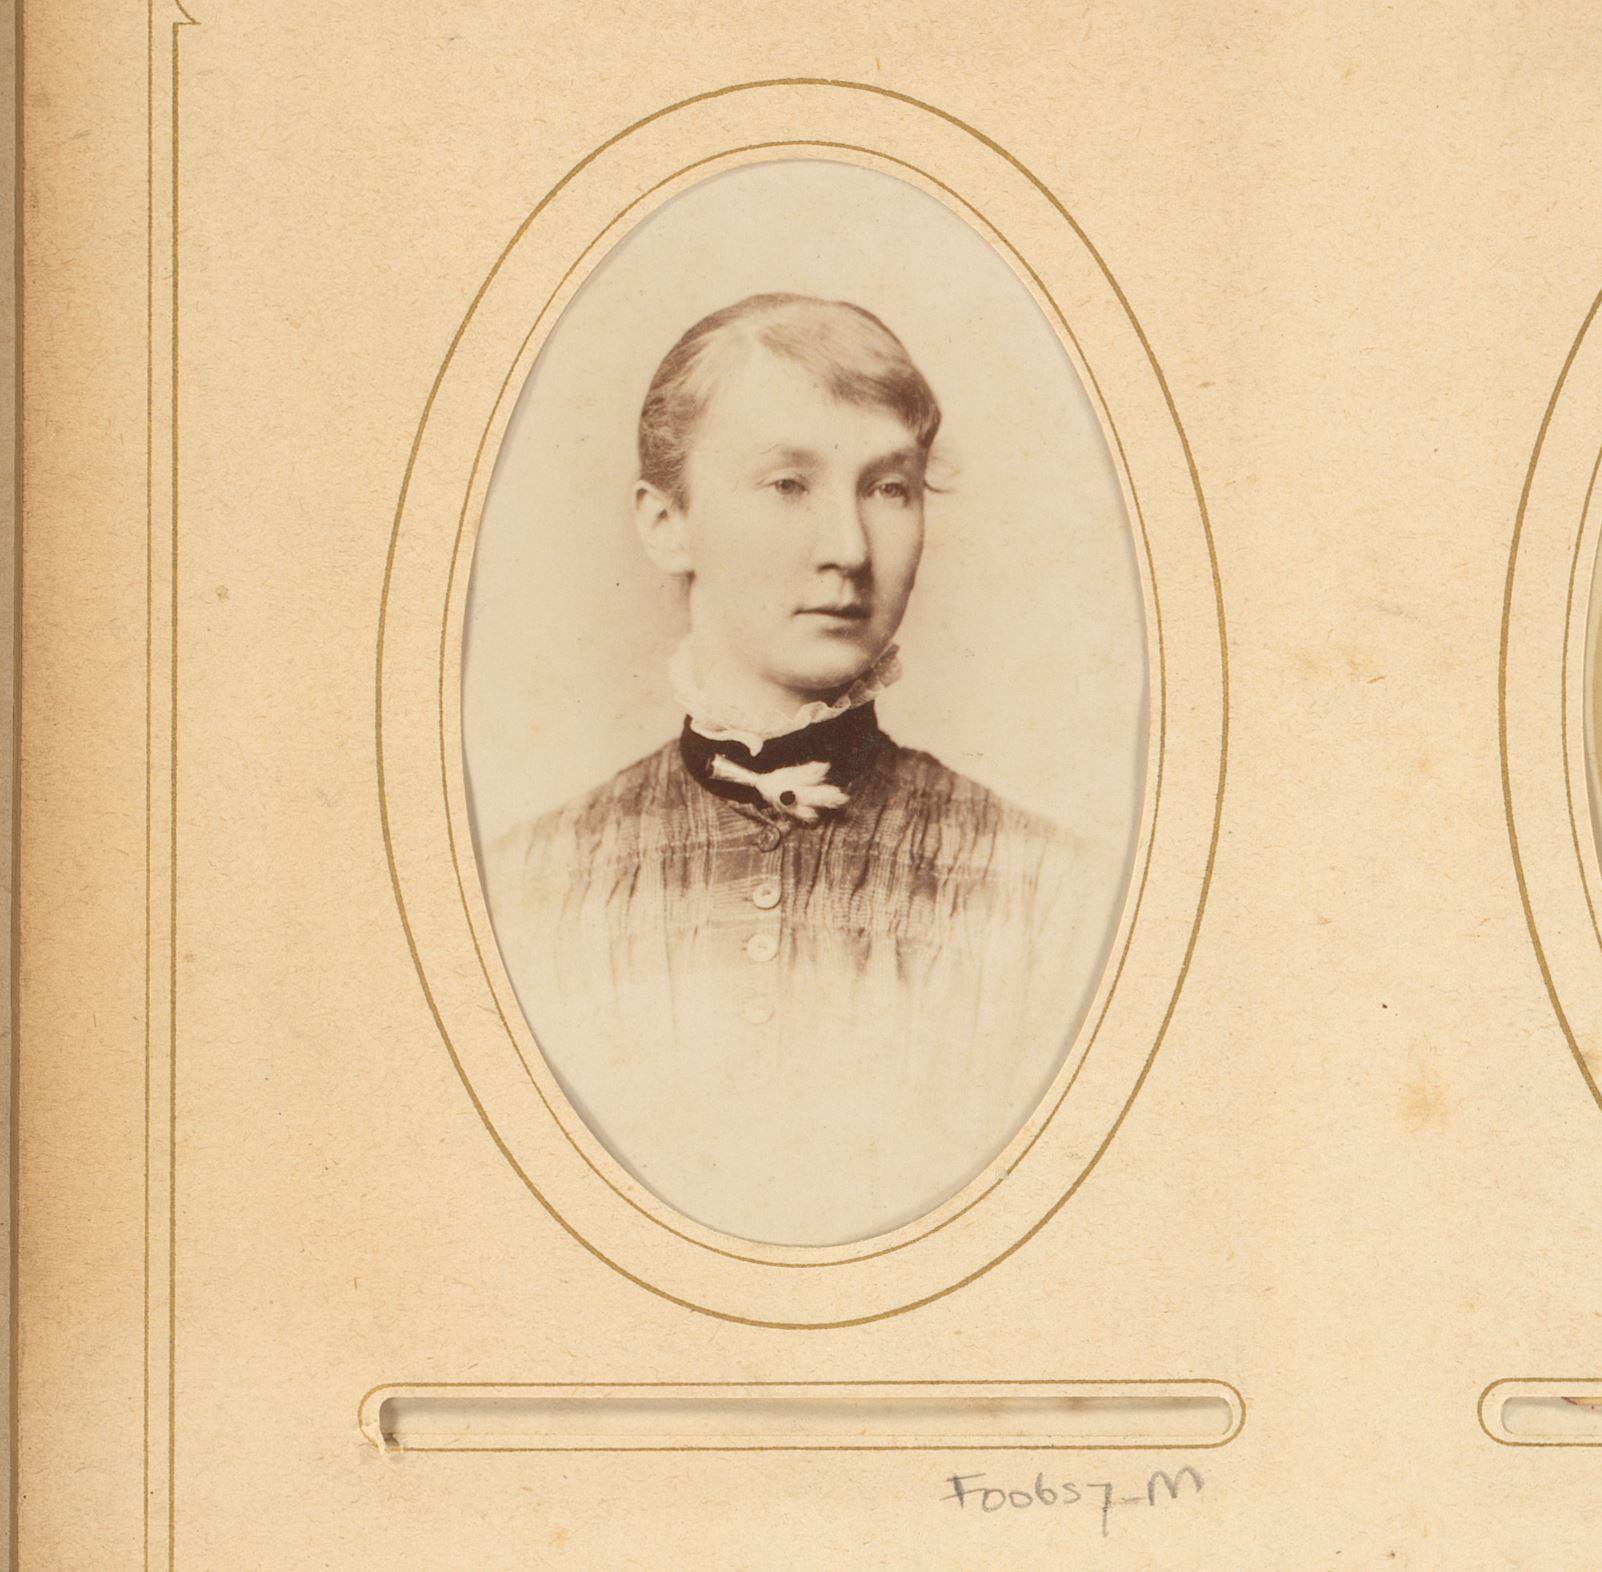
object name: carte de visite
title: Portret van een vrouw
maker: valentine blanchard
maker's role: fotograaf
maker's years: 1831-1901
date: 1856-1884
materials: cardboard, photographic support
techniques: albumen print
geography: cambridge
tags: historical persons - bb - woman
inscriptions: inscription: ‘Valentine Blanchard/ Photographer/ (SUCCESSOR TO J.E. BLISS)/ Post Office Terrace/ Cambridge’